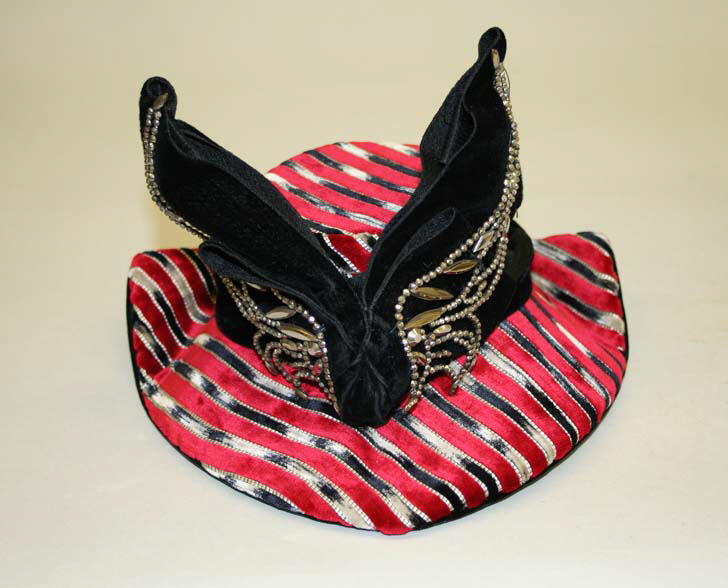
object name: hat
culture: american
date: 1890-1899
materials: silk